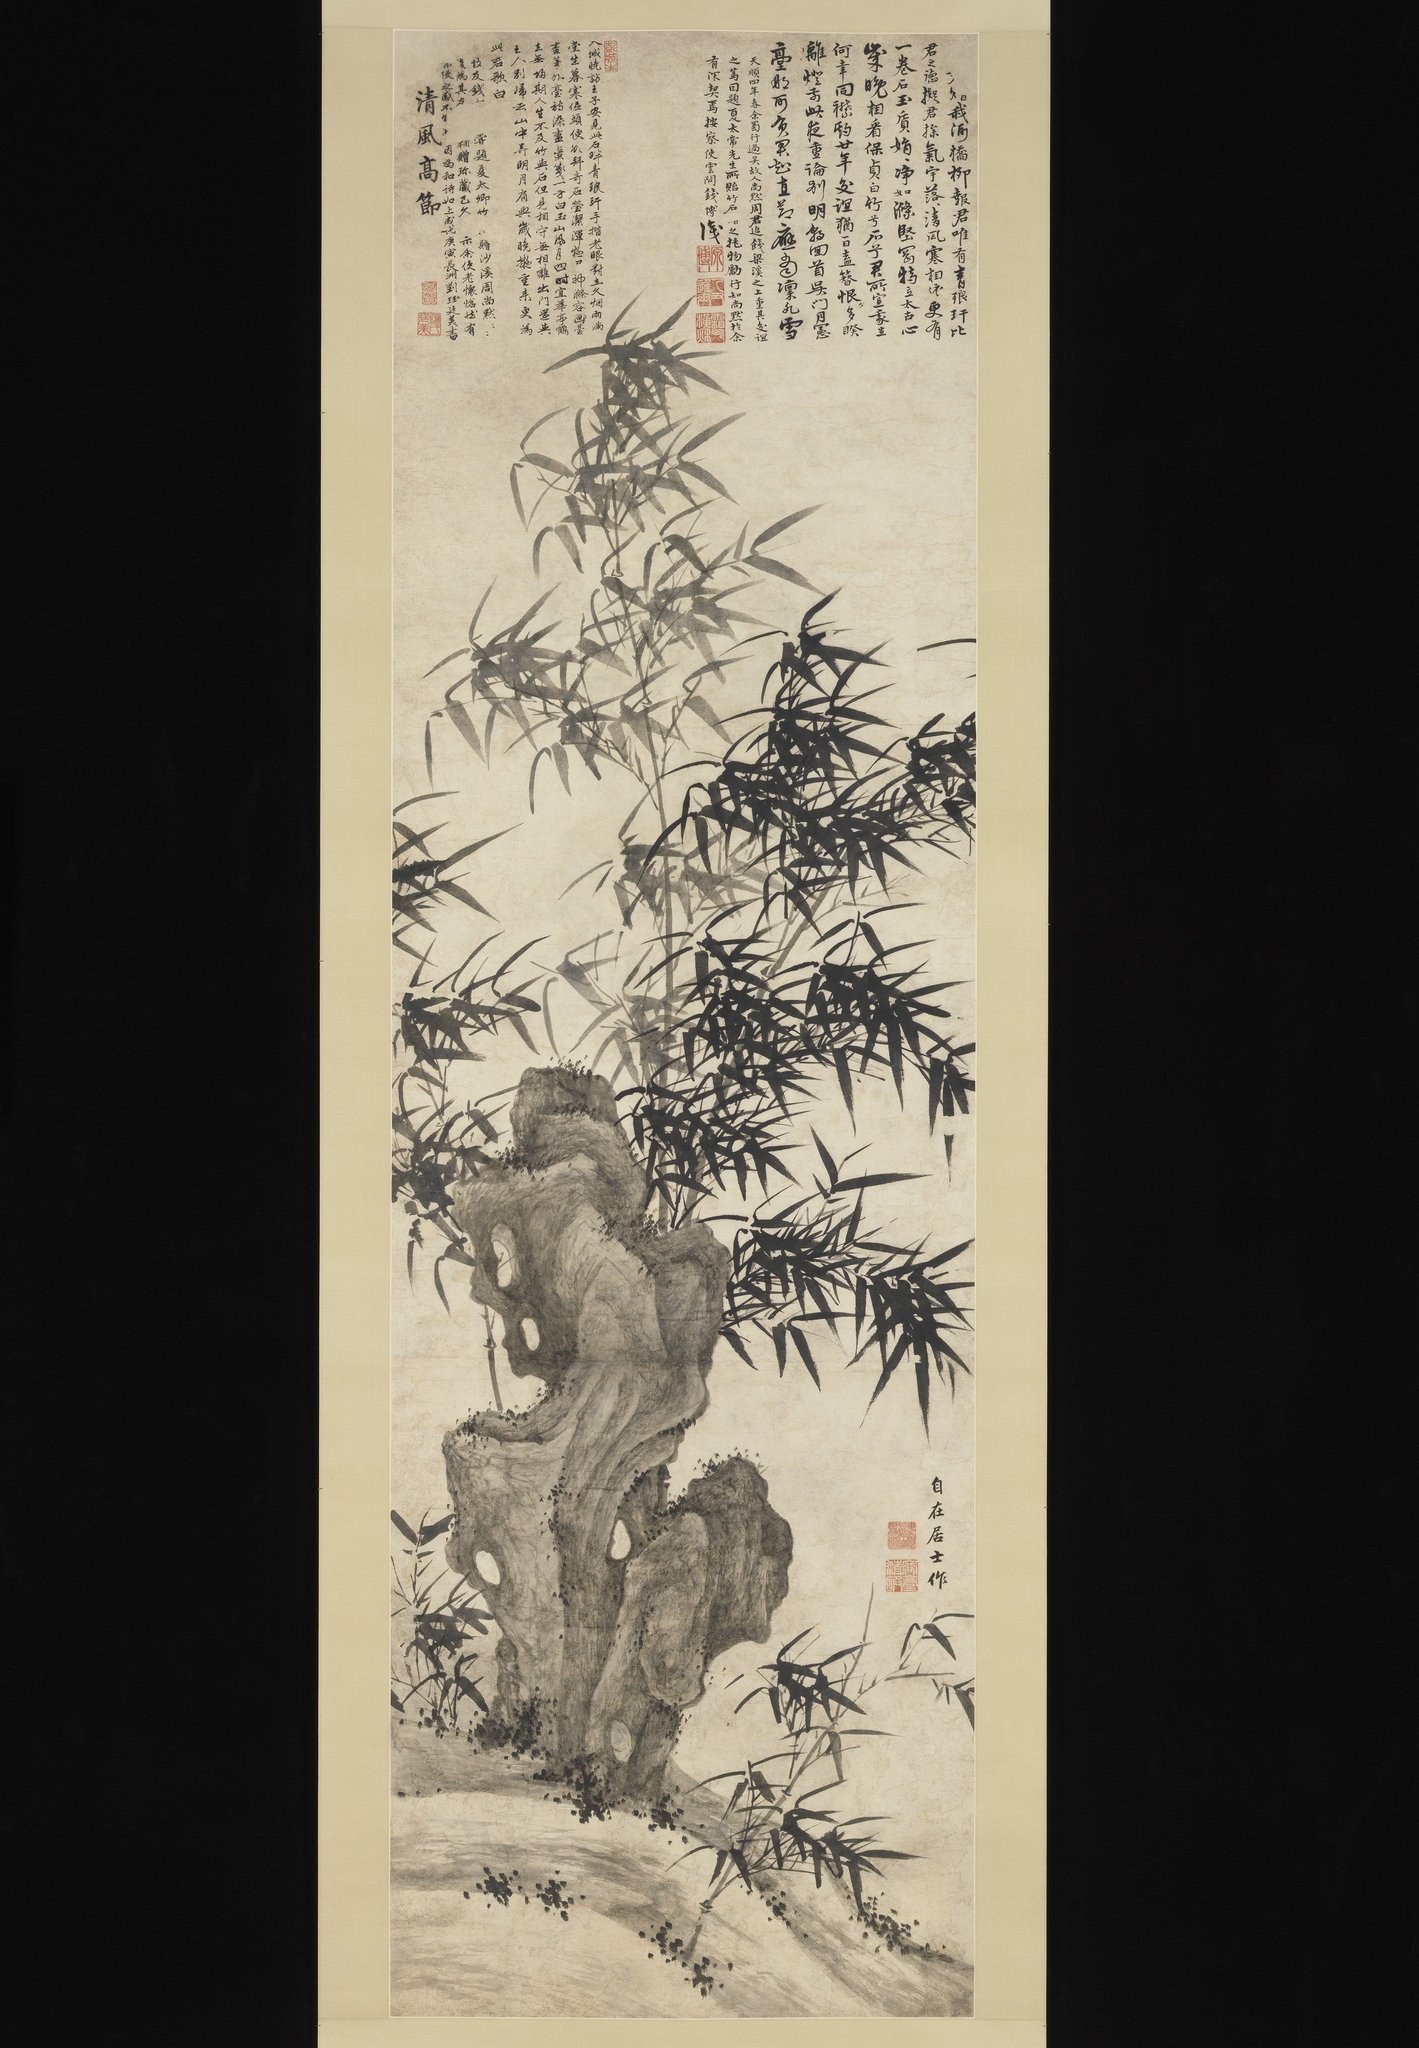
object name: hanging scroll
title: Windblown bamboo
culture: chinese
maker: xia chang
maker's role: artist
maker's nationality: chinese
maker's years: 1388-1470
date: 1460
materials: ink, paper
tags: bamboo